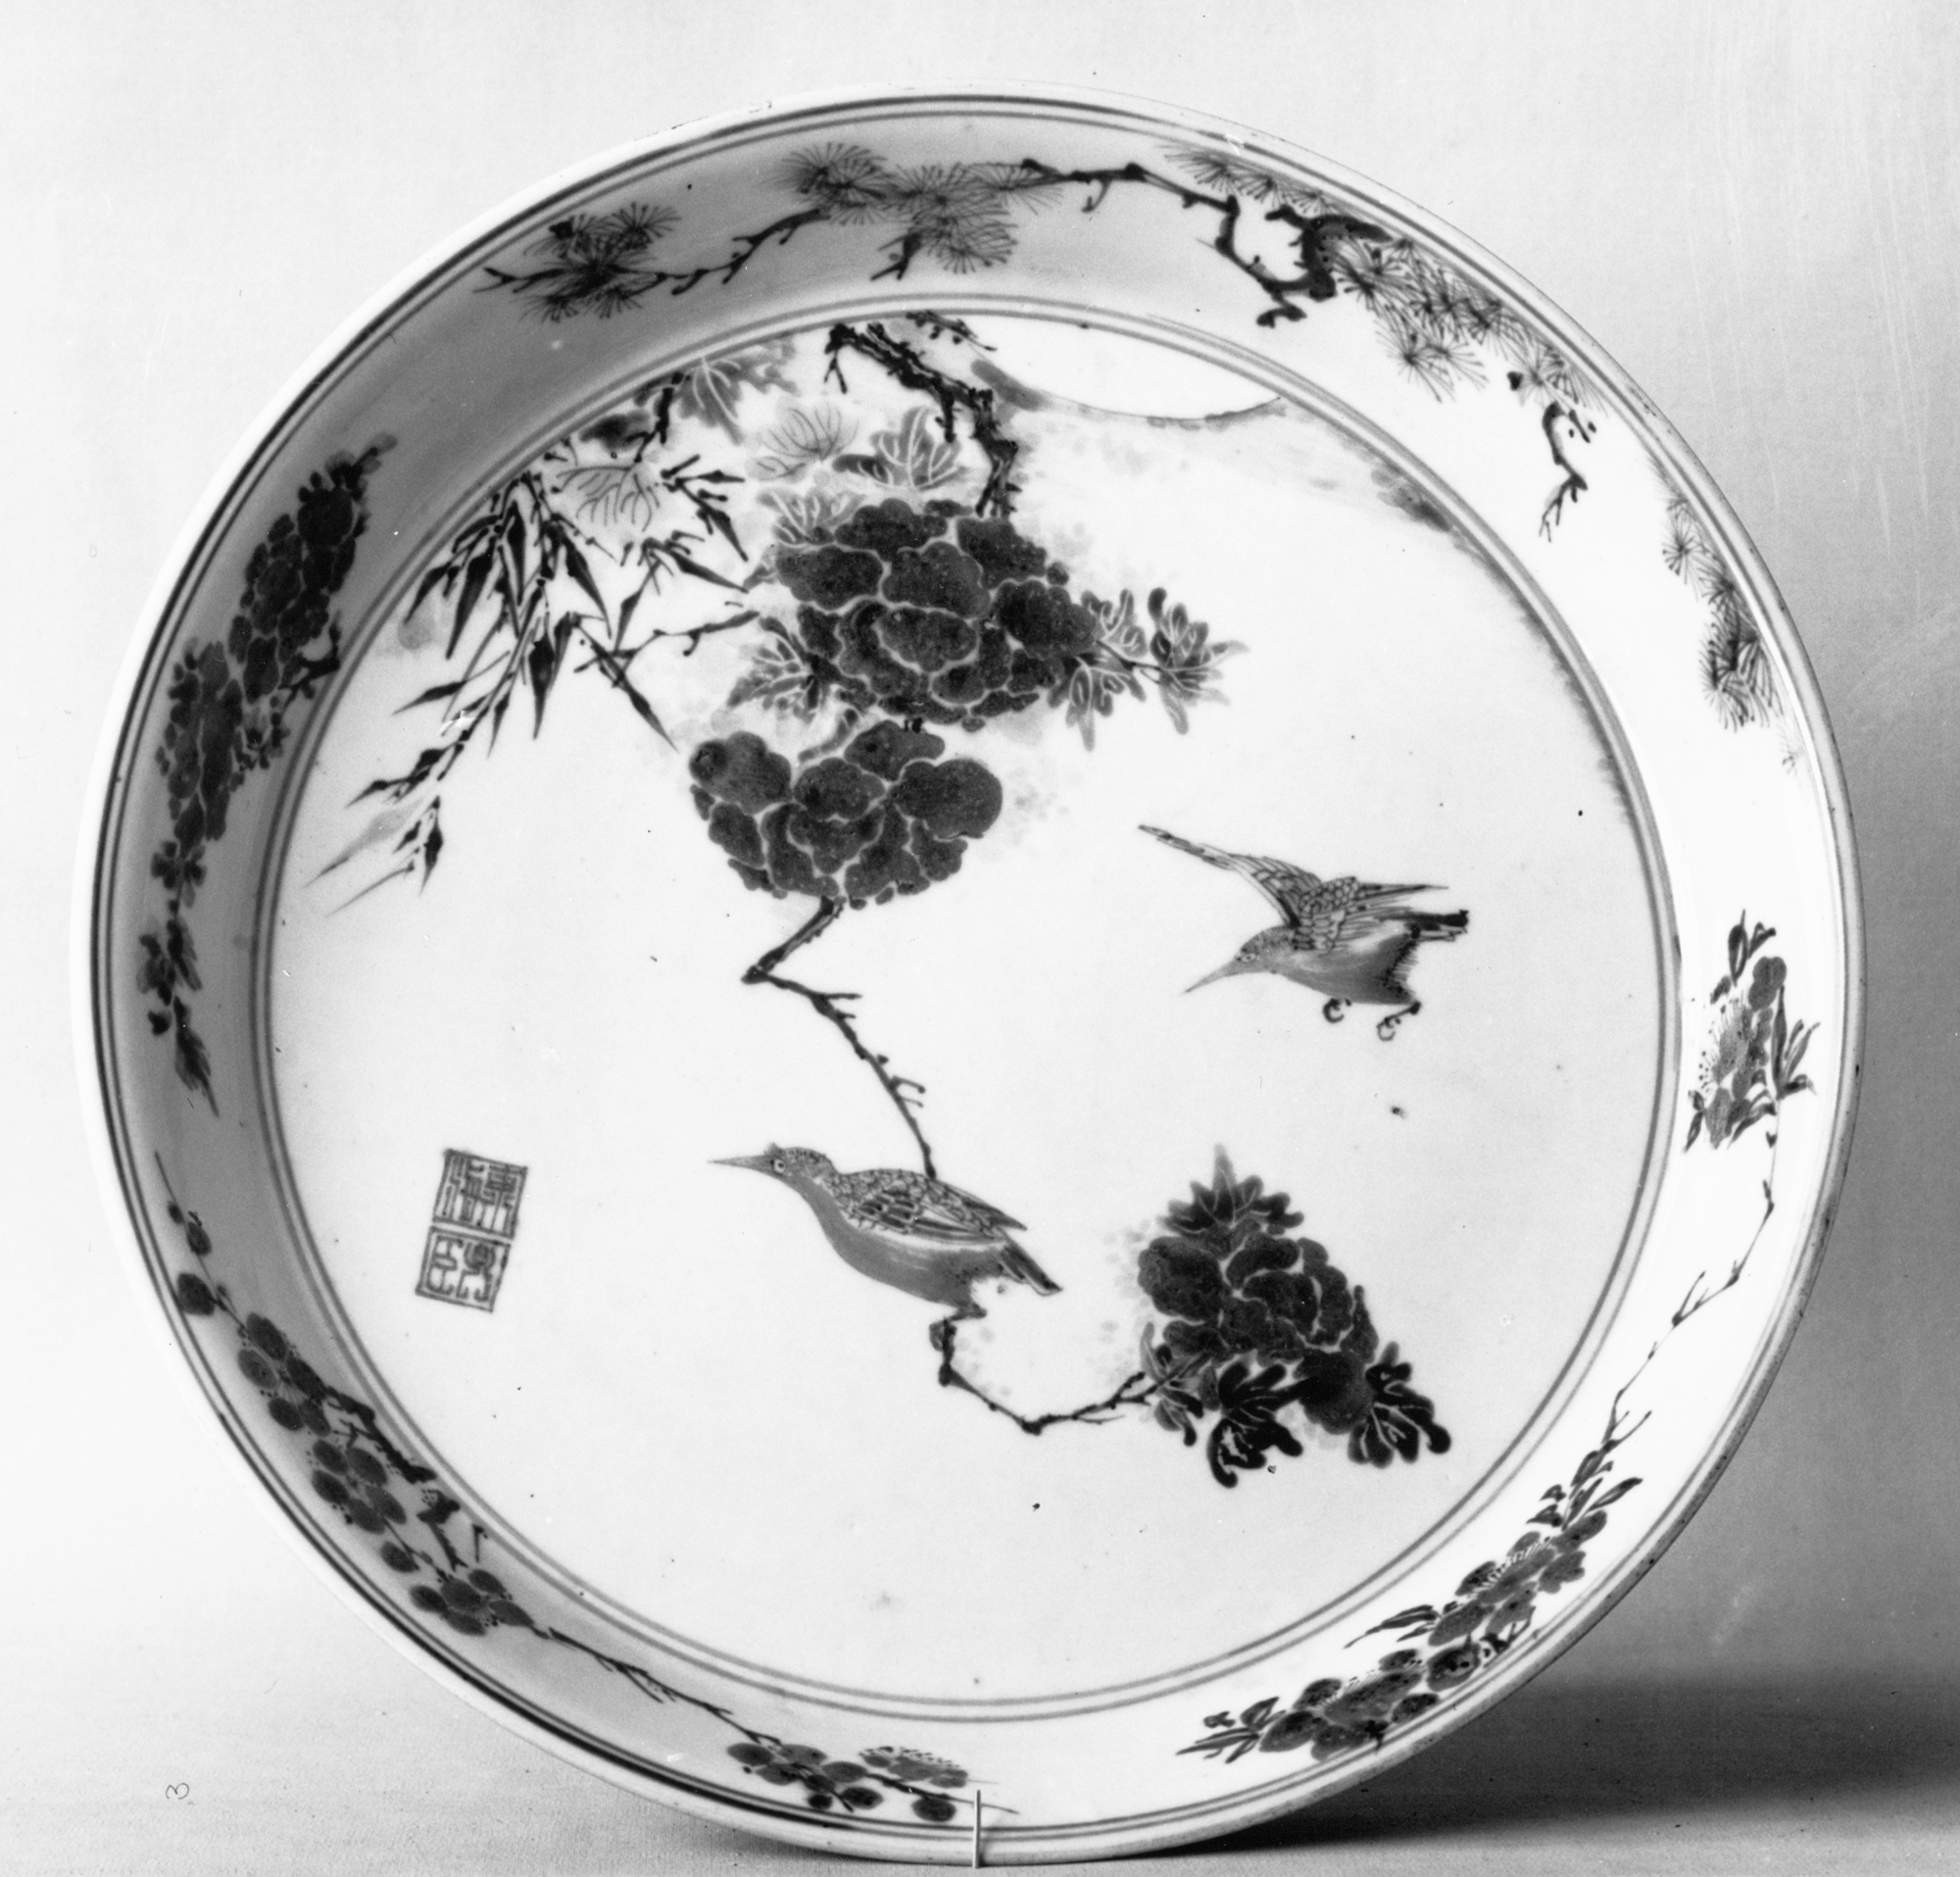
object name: plate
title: Plate with Bamboo, Peonies, and Birds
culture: chinese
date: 1662-1722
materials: cobalt, copper, glaze, porcelain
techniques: painting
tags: birds,peonies